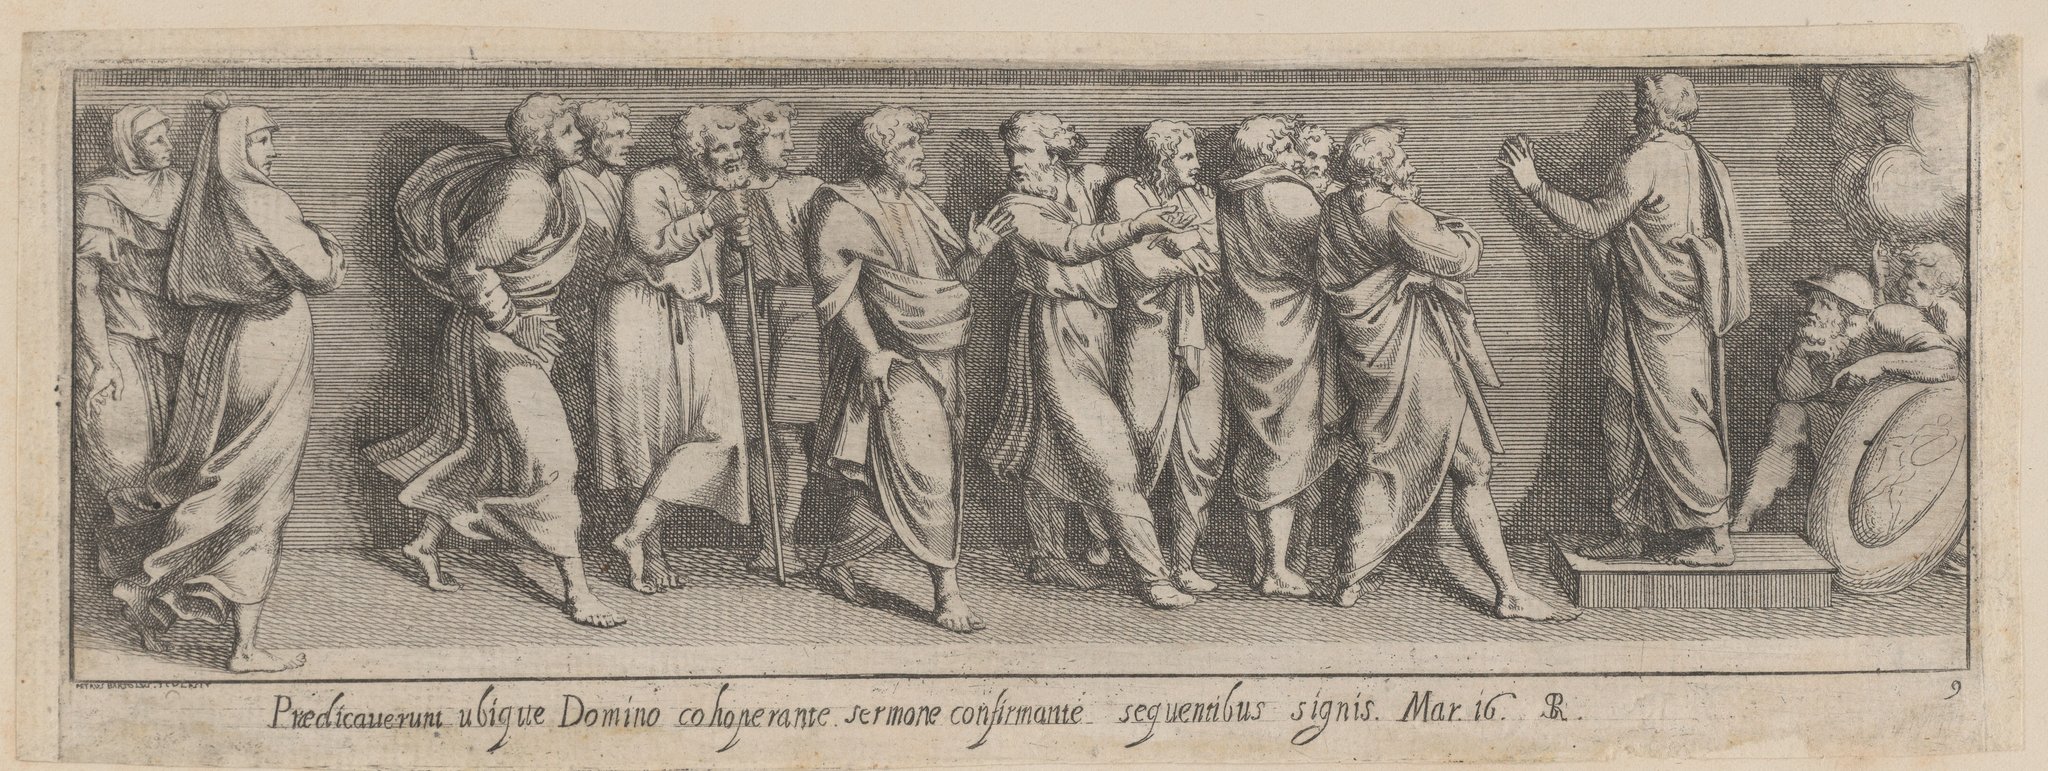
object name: print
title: Plate 9: Joshua, standing at right, speaks to the people of Israel, after a lost fresco in the basamento of Bay 10 of the Vatican Loggia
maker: pietro santi bartoli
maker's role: artist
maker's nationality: italian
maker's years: 1615-1700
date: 1650-1677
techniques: etching